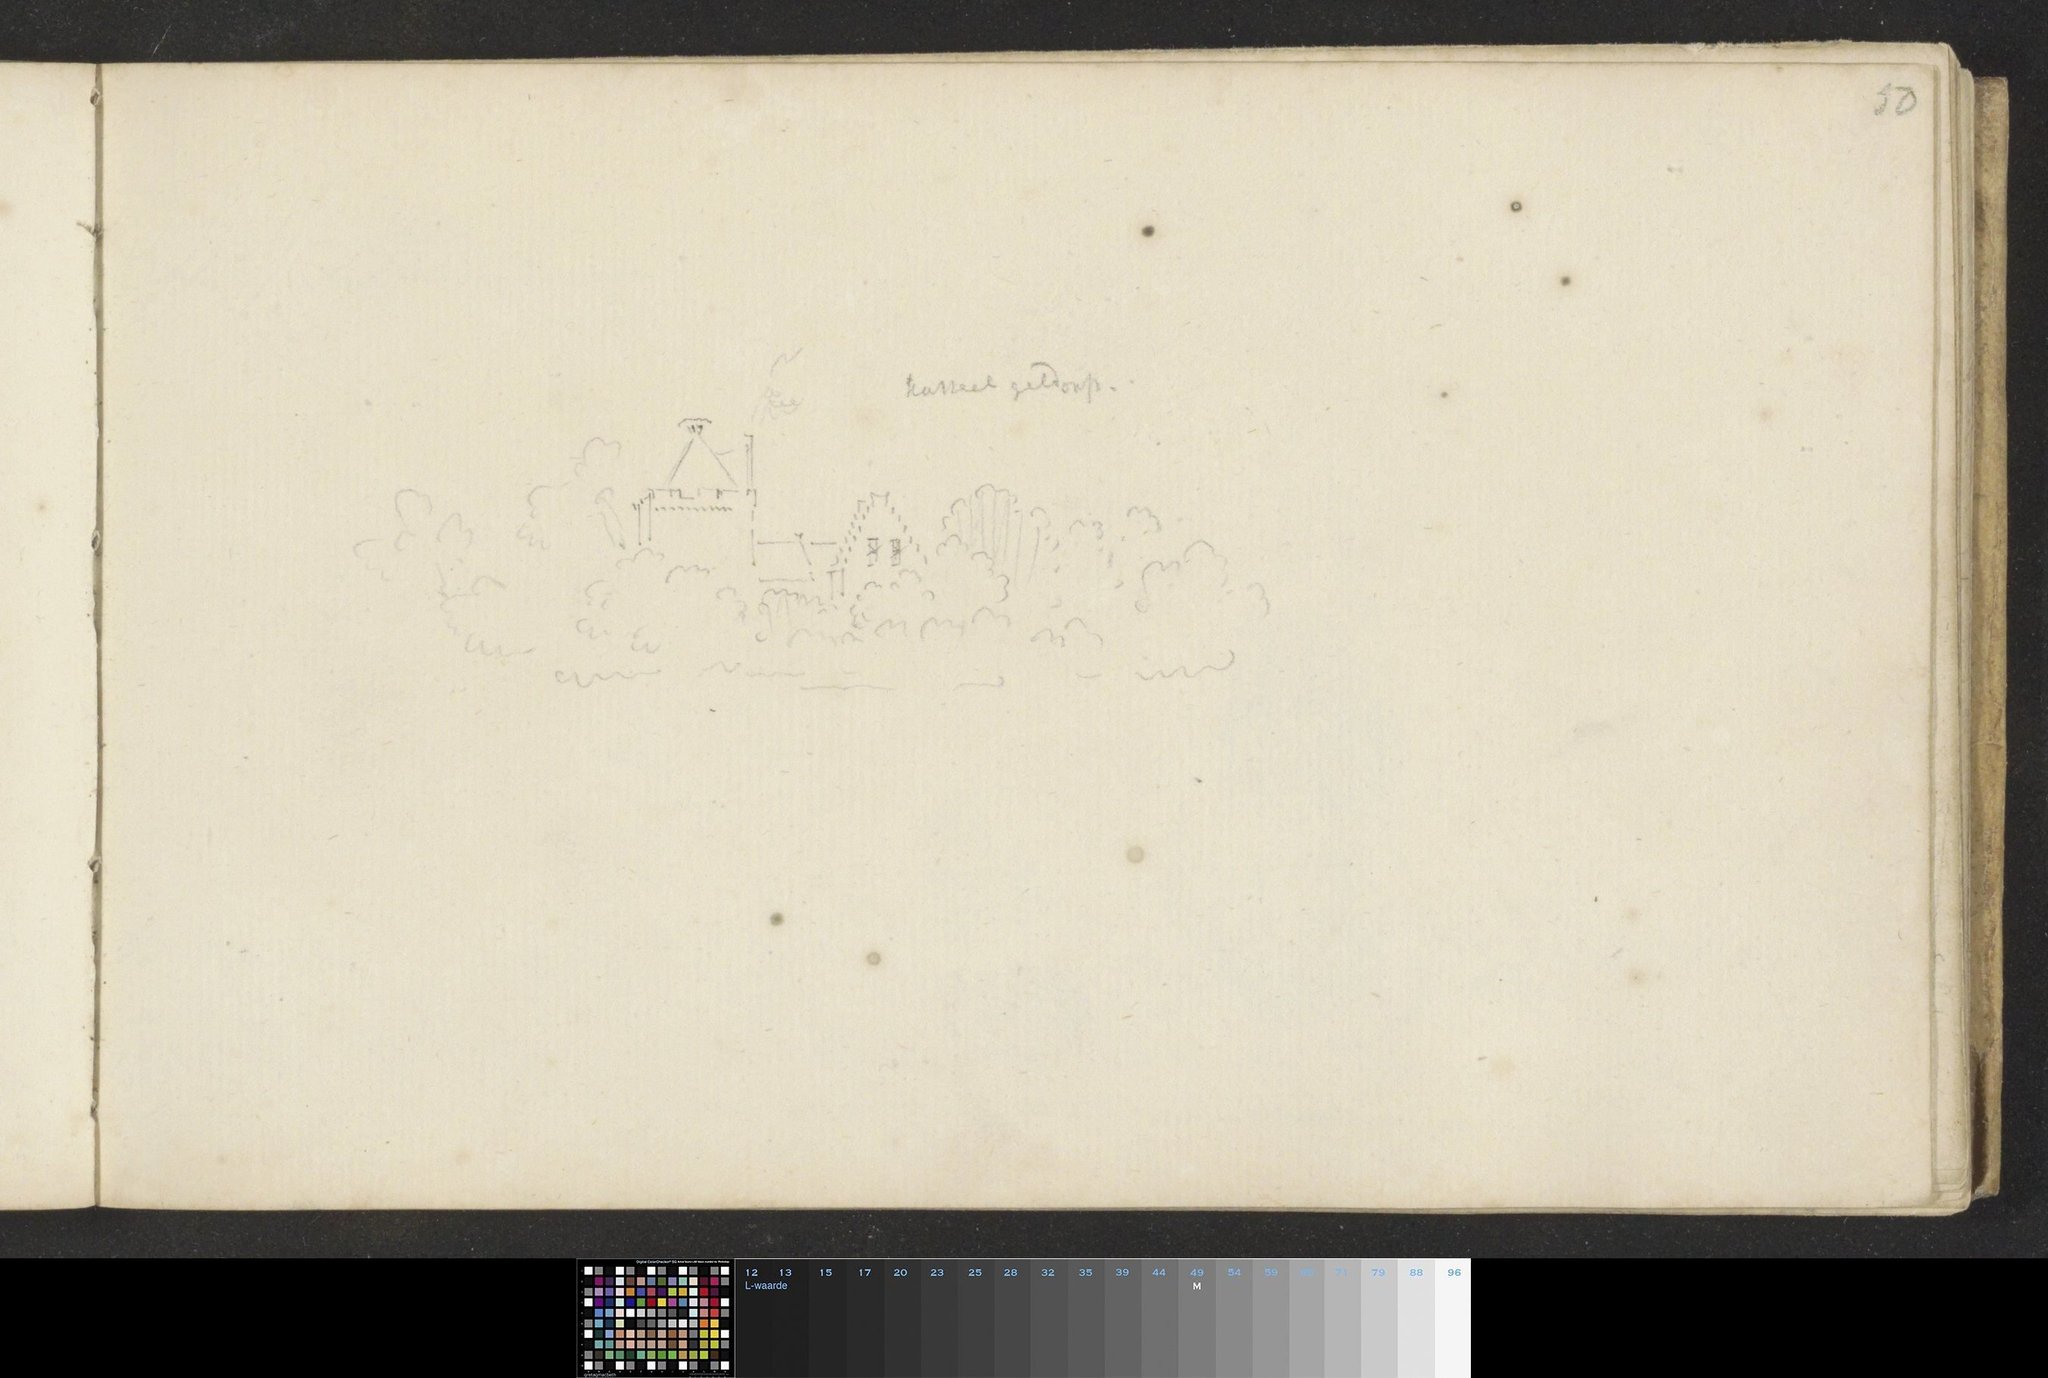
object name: sketchbook leaf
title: Kasteel Geldrop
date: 1701-1759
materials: paper, pencil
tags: castle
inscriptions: annotation: ‘kasteel geldrop.’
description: Blad 50 recto uit een schetsboek met 65 bladen.